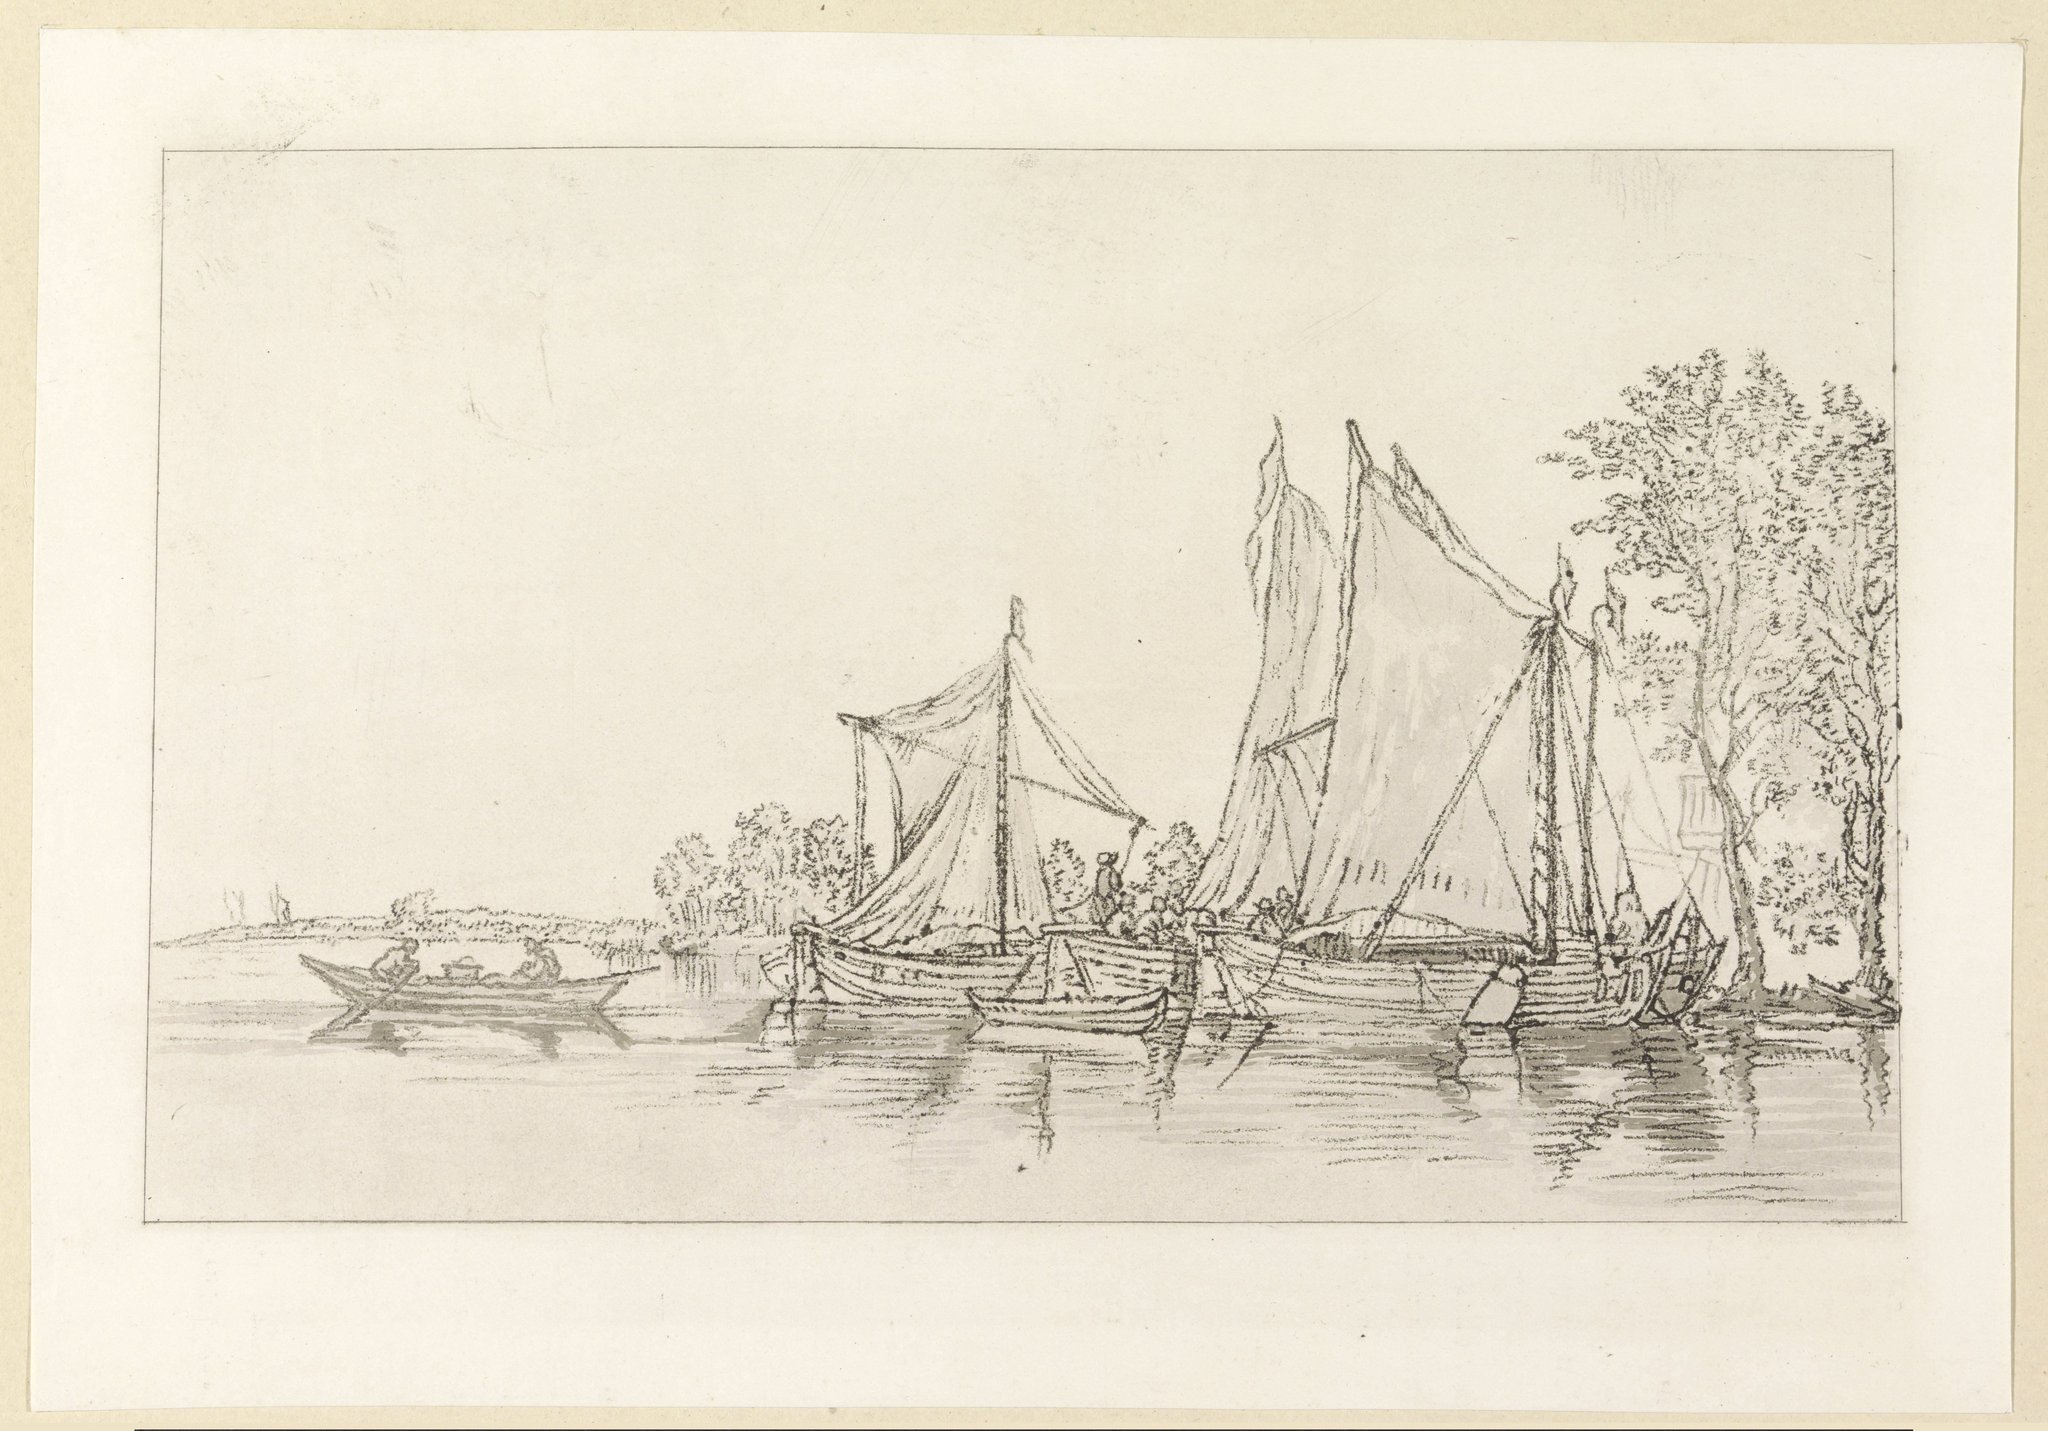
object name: print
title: Riviergezicht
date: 1795-1821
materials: paper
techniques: printmaking, etching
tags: river, traffic on the water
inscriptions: collector's mark: Lugt 2228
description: De voltooide prent werd opgenomen in: Collection d'imitations de dessins d'après les principaux maîtres hollandais et flamands, Londen, C. Josi, 1821.